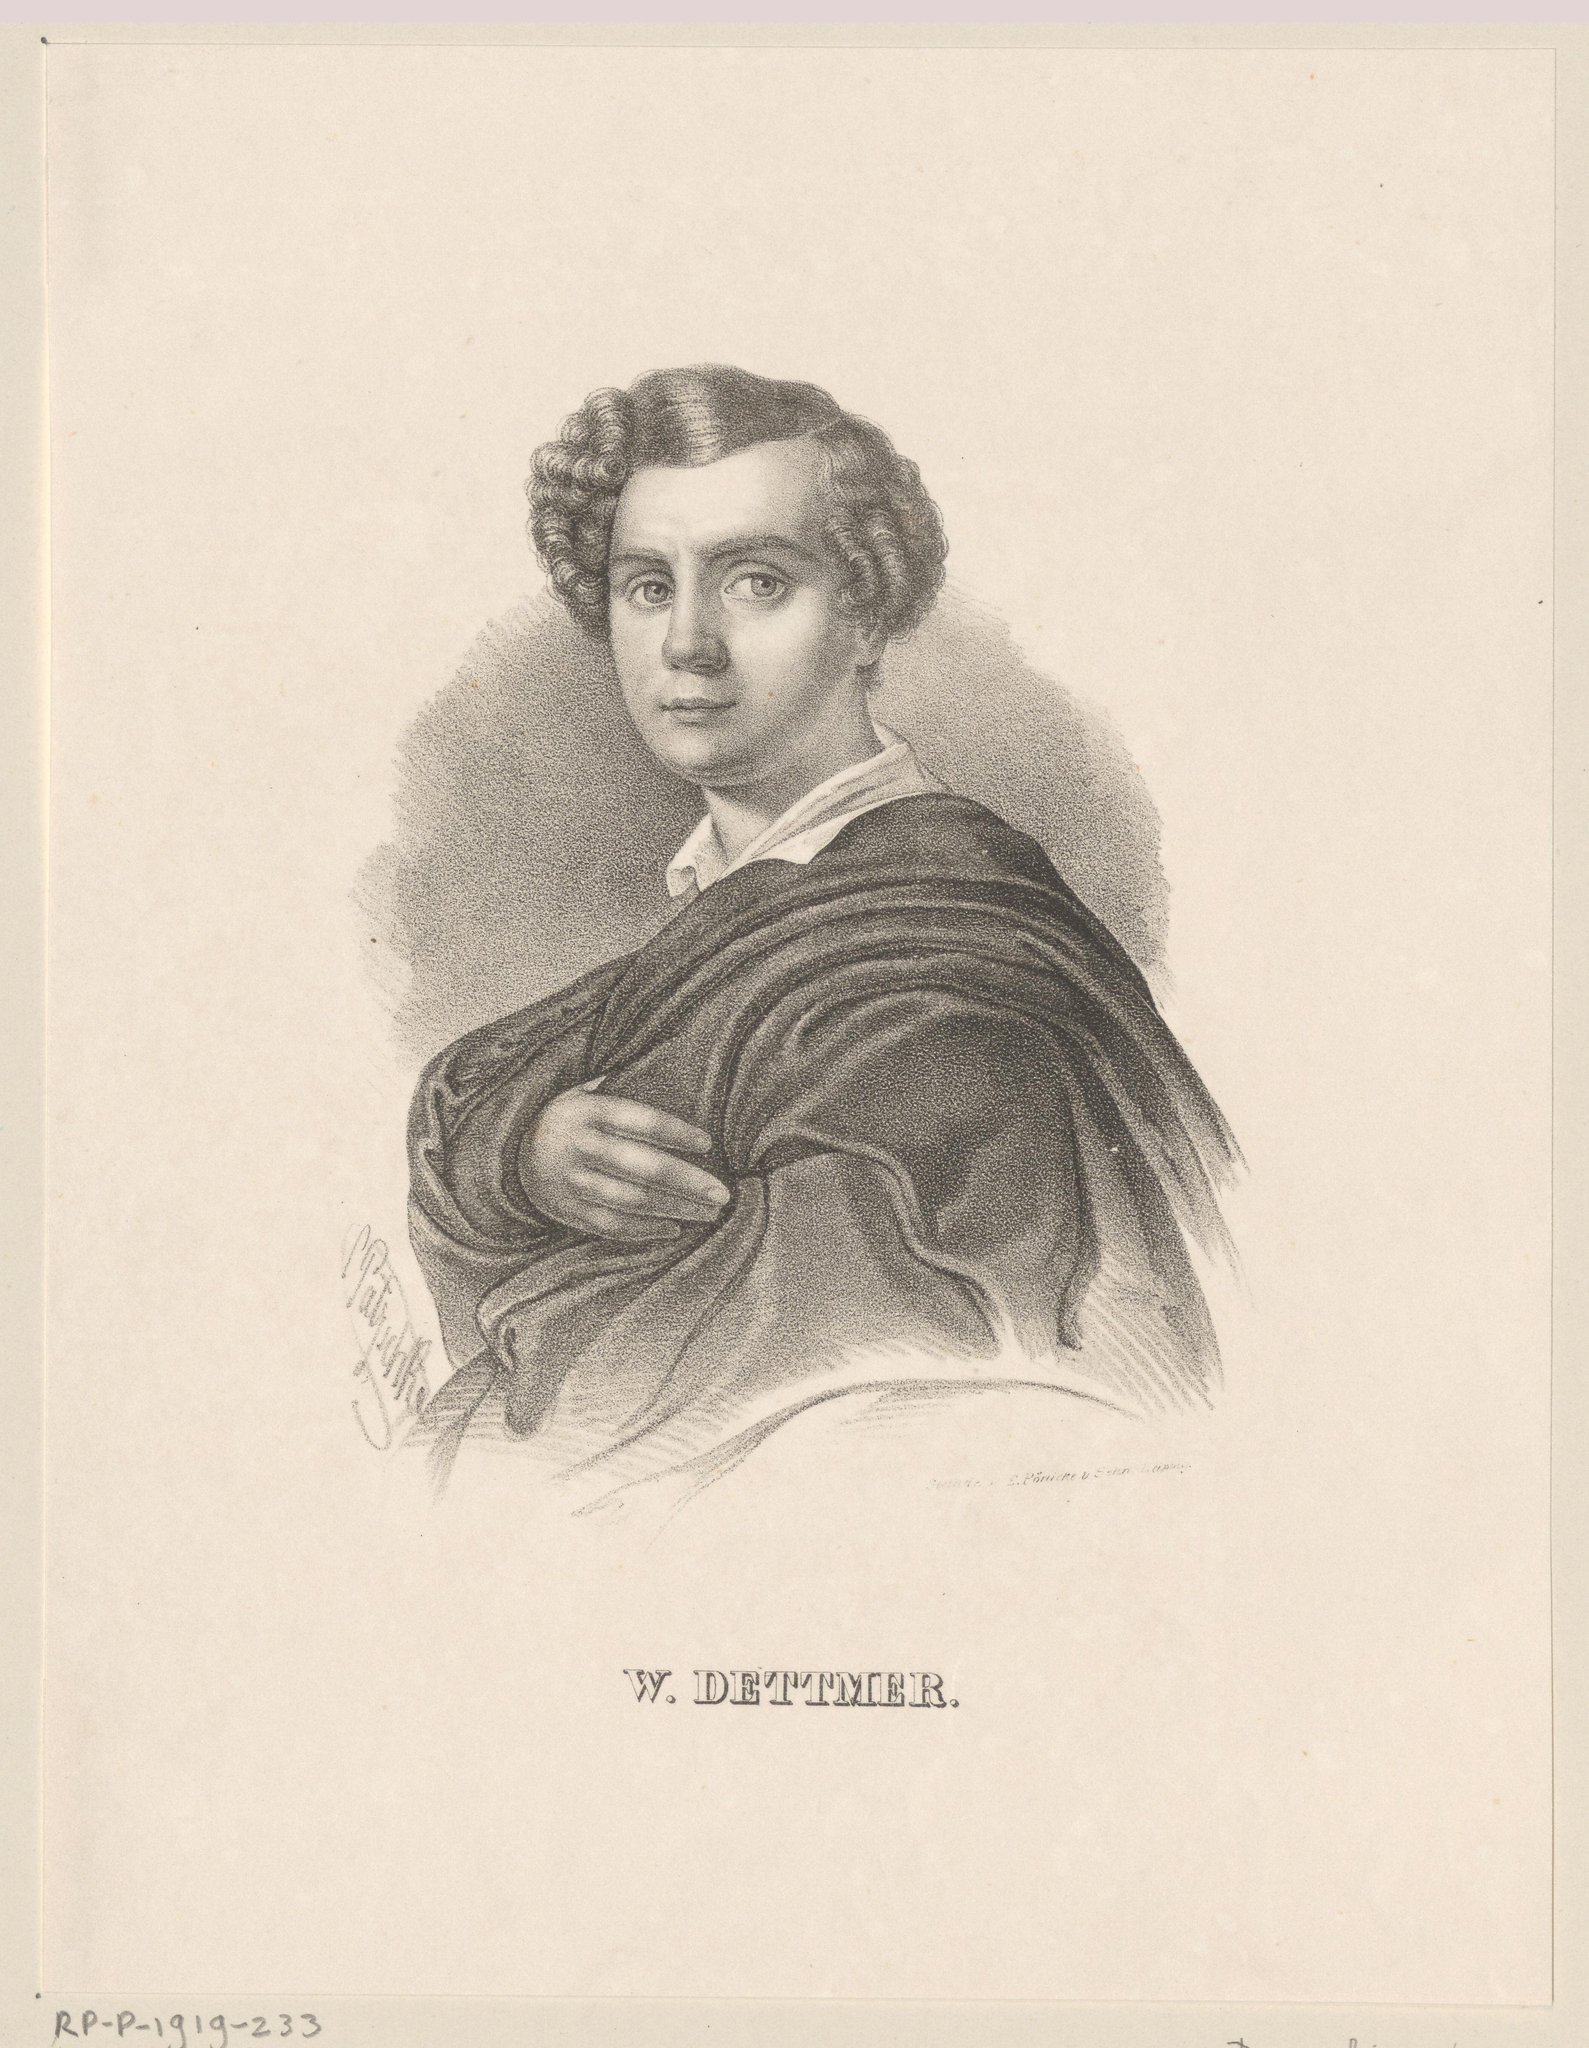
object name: print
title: Portret van Georg Wilhelm Dettmer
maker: carl friedrich patzschke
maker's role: print maker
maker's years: 1813-1871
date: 1840-1848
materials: paper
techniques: lithograph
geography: leipzig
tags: historical persons, opera-singer (male)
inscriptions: collector's mark: Lugt 2228